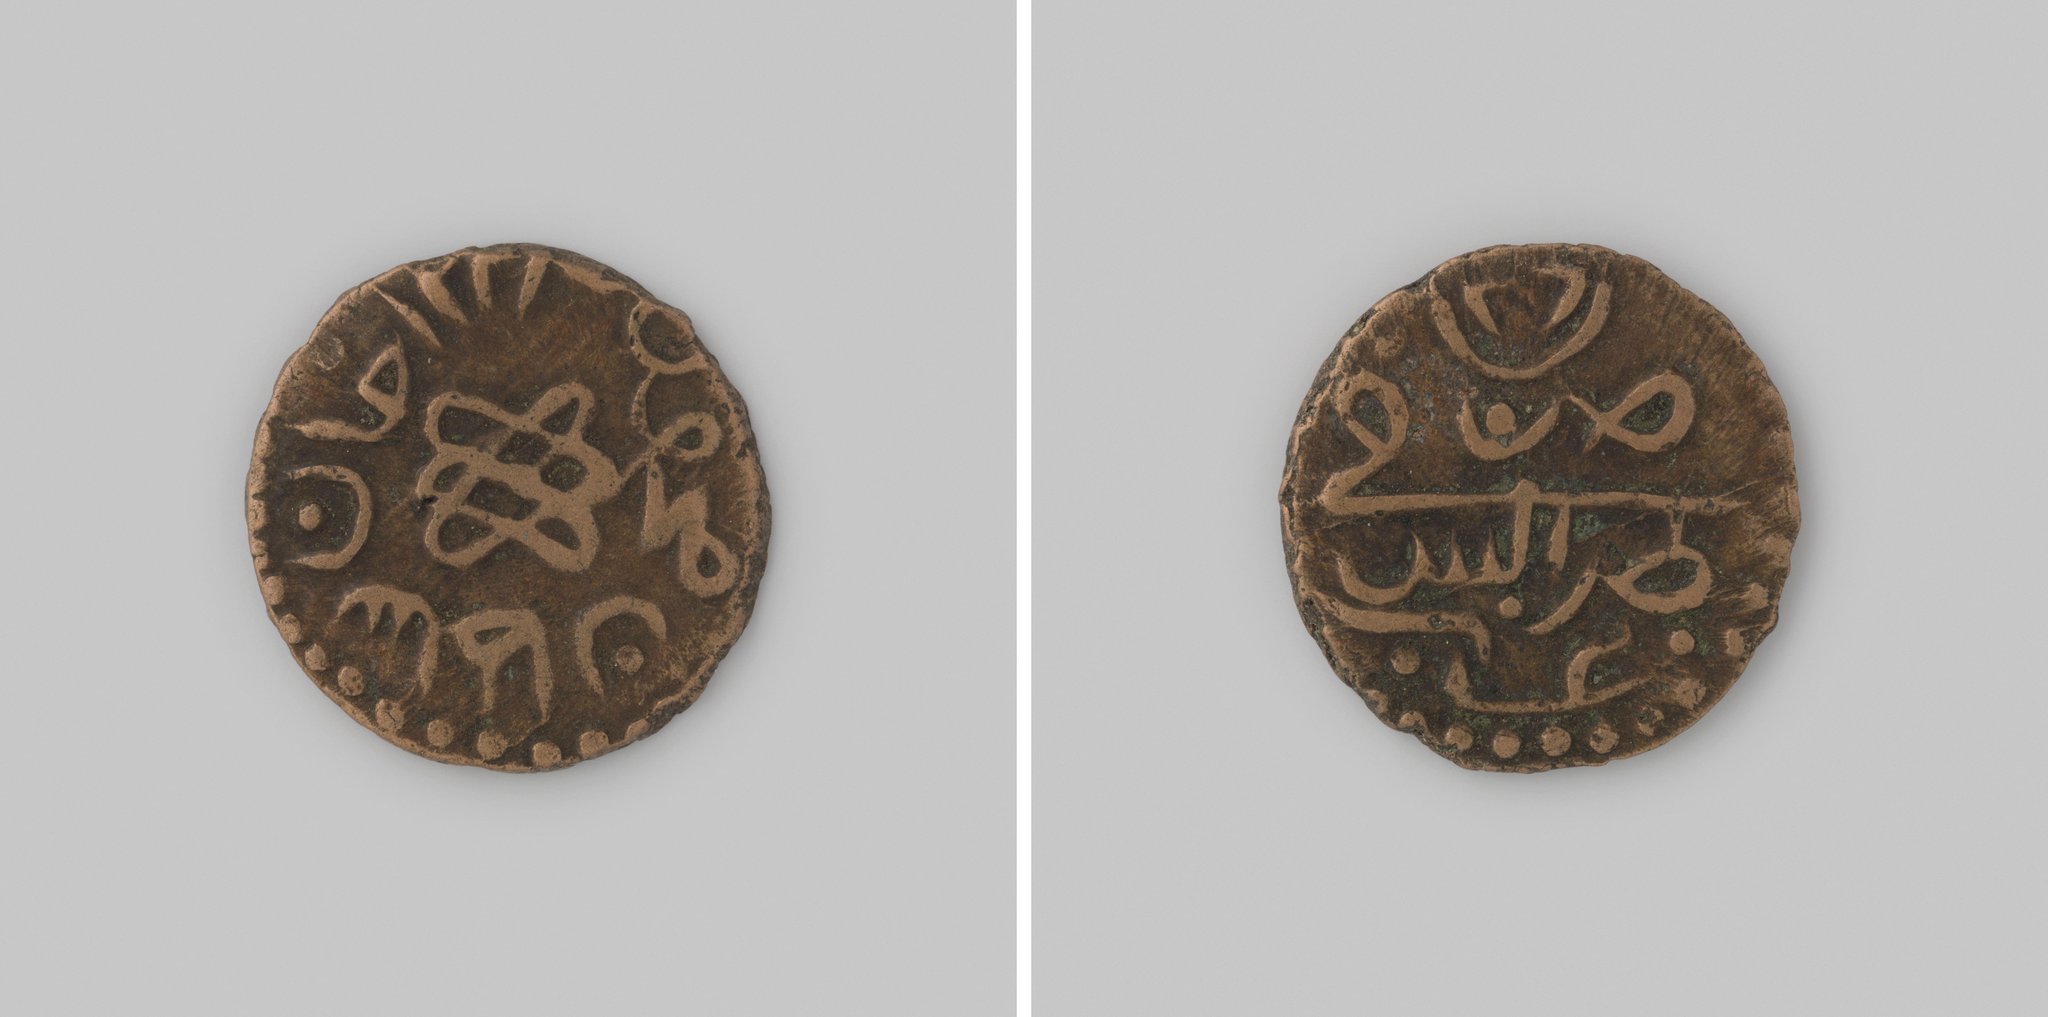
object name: coin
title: Para uit Libie van de Ottomaanse sultan Mahmud II, regeringsjaar 26 [=1833]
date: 1833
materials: copper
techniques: striking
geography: tripoli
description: Koperen munt. Voorzijde: arabesk, waaromheen omschrift in Arabische letters. Bovenaan jaar van aantreden: 1223 [=1808]. Keerzijde: vierregelig opschrift in Arabische letters met muntplaats-aanduiding: Tarablusi gharb [=Tripoli in Libië]. Boven in opschrift regeringsjaar: 26. Gladde rand.